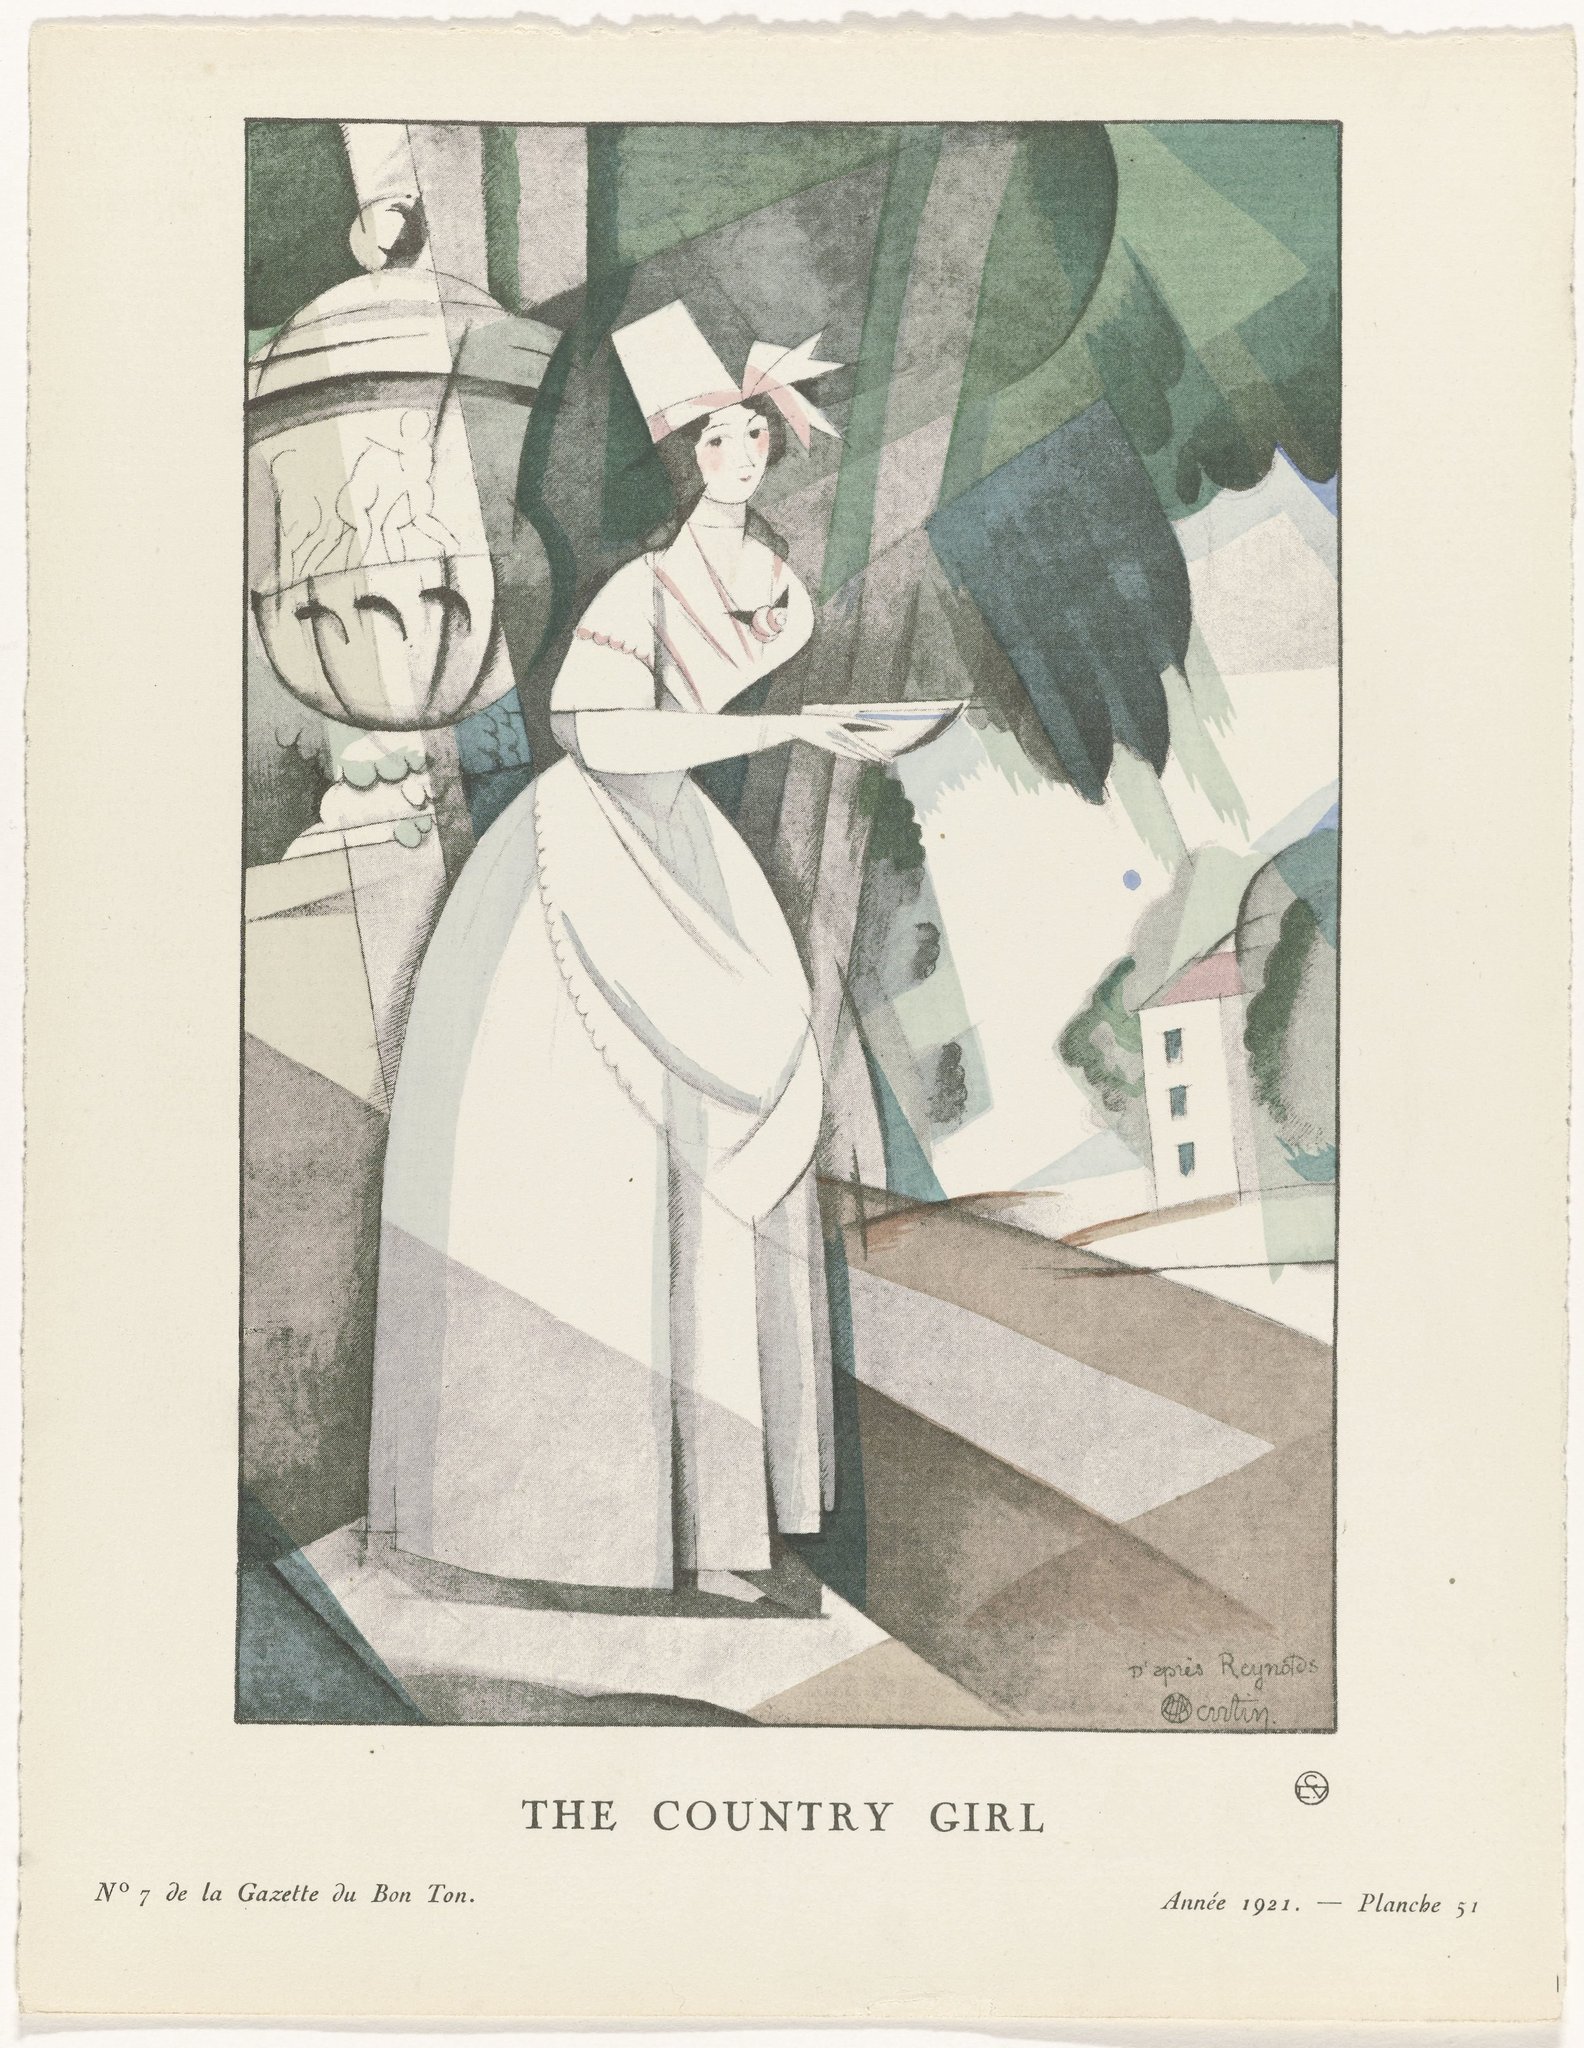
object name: fashion print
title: Gazette du Bon Ton, 1921 - No. 7, Pl. 51: The country girl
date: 1921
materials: paper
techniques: hand coloring, letterpress printing, photochemical processes, pochoir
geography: buenos aires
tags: head-gear (+ women's clothes), fashion plates, dress, gown (+ women's clothes), garden vase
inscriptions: date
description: Jonge vrouw bij een tuinvaas, gekleed in een eenvoudige japon met op het hoofd een hoge hoed. In de handen een schaal. Planche 51 uit Gazette du Bon Ton 1921, No. 7. Uitleg over de kleding op pagina "Explication des Planches Hors-Texte. Contenues dans le numéro 7."